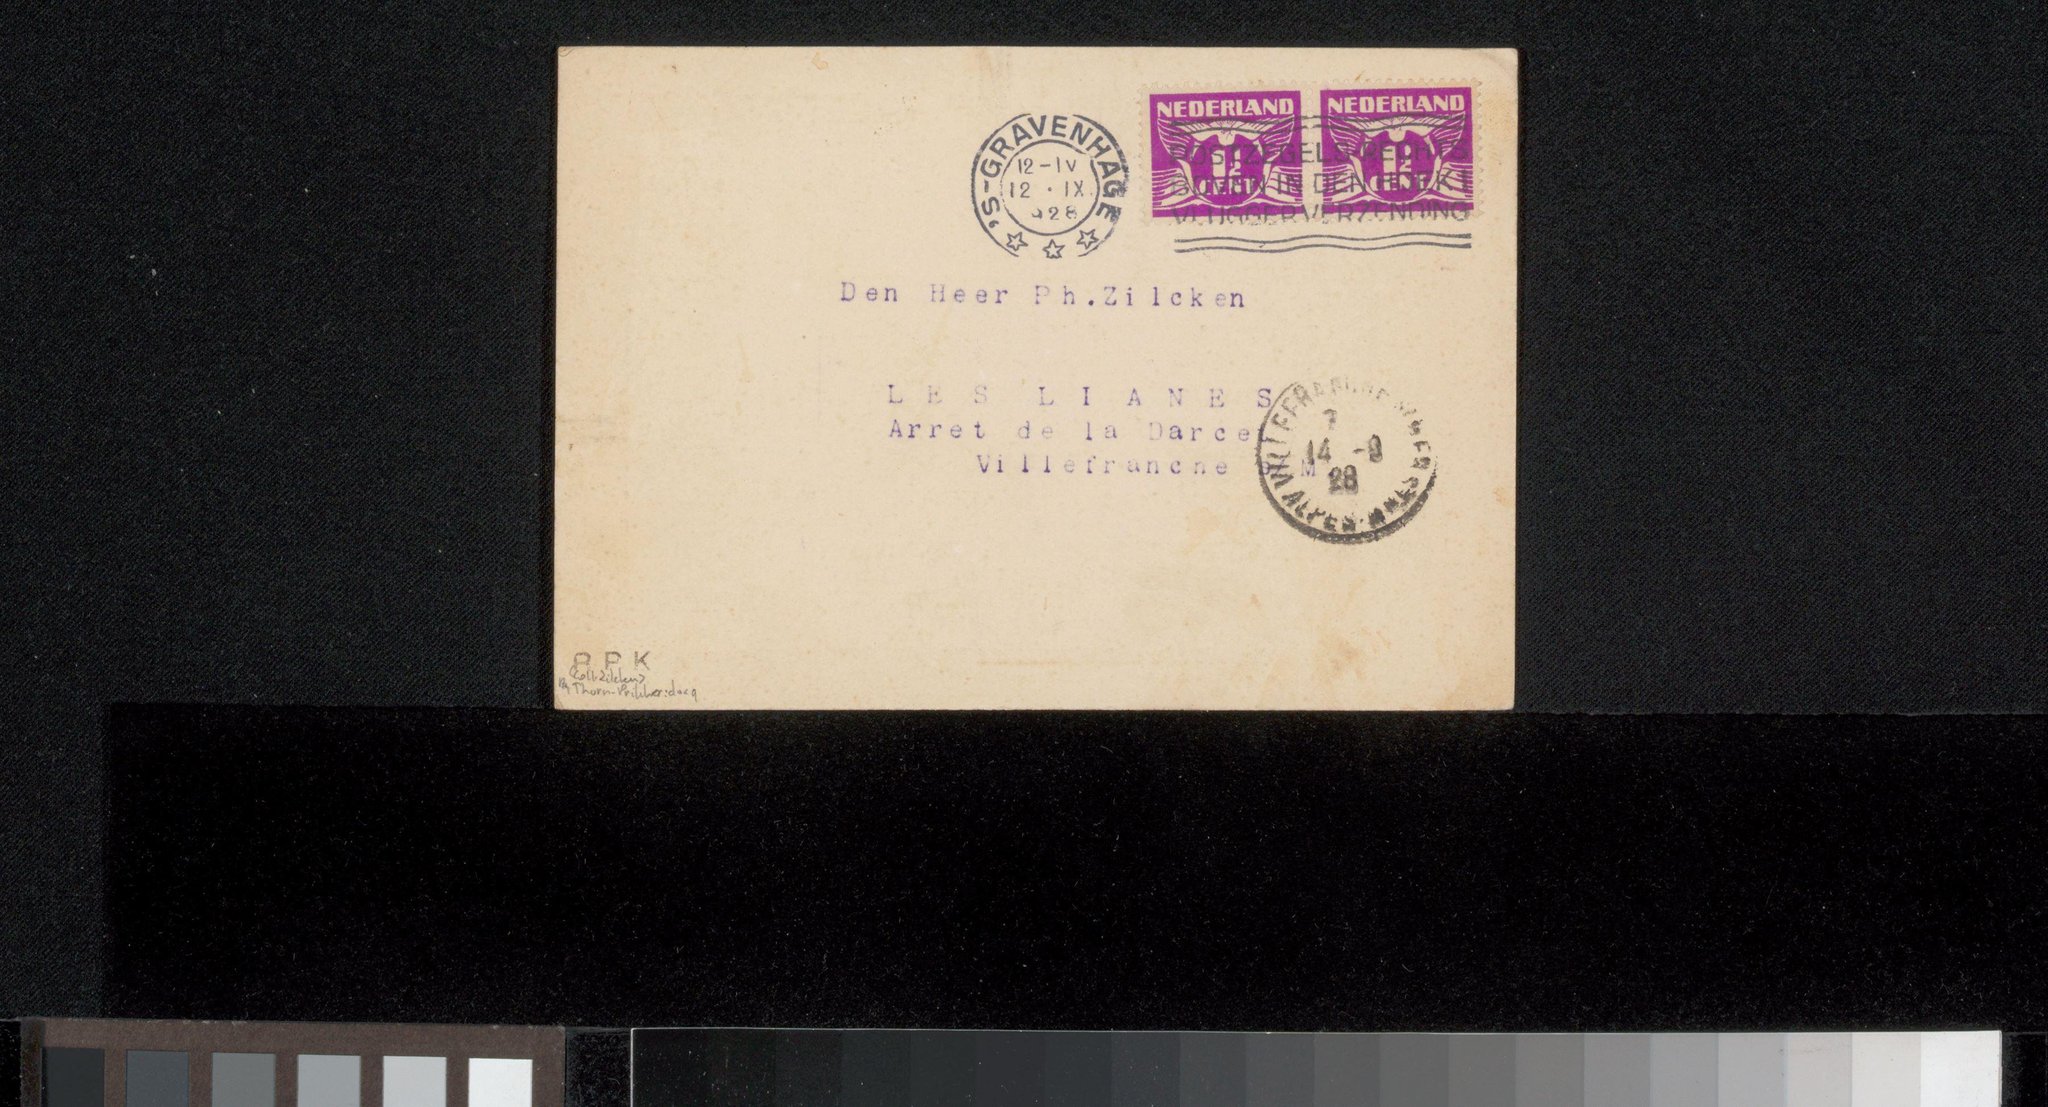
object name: invitation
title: Uitnodiging aan Philip Zilcken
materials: paper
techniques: printing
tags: the hague, cologne, print maker, draughtsman, johan thorn prikker, dordrecht, henri borel, willem leuring, painter, philip zilcken, criticizing and discussing art, art criticism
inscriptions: collector's mark: ‘RPK’